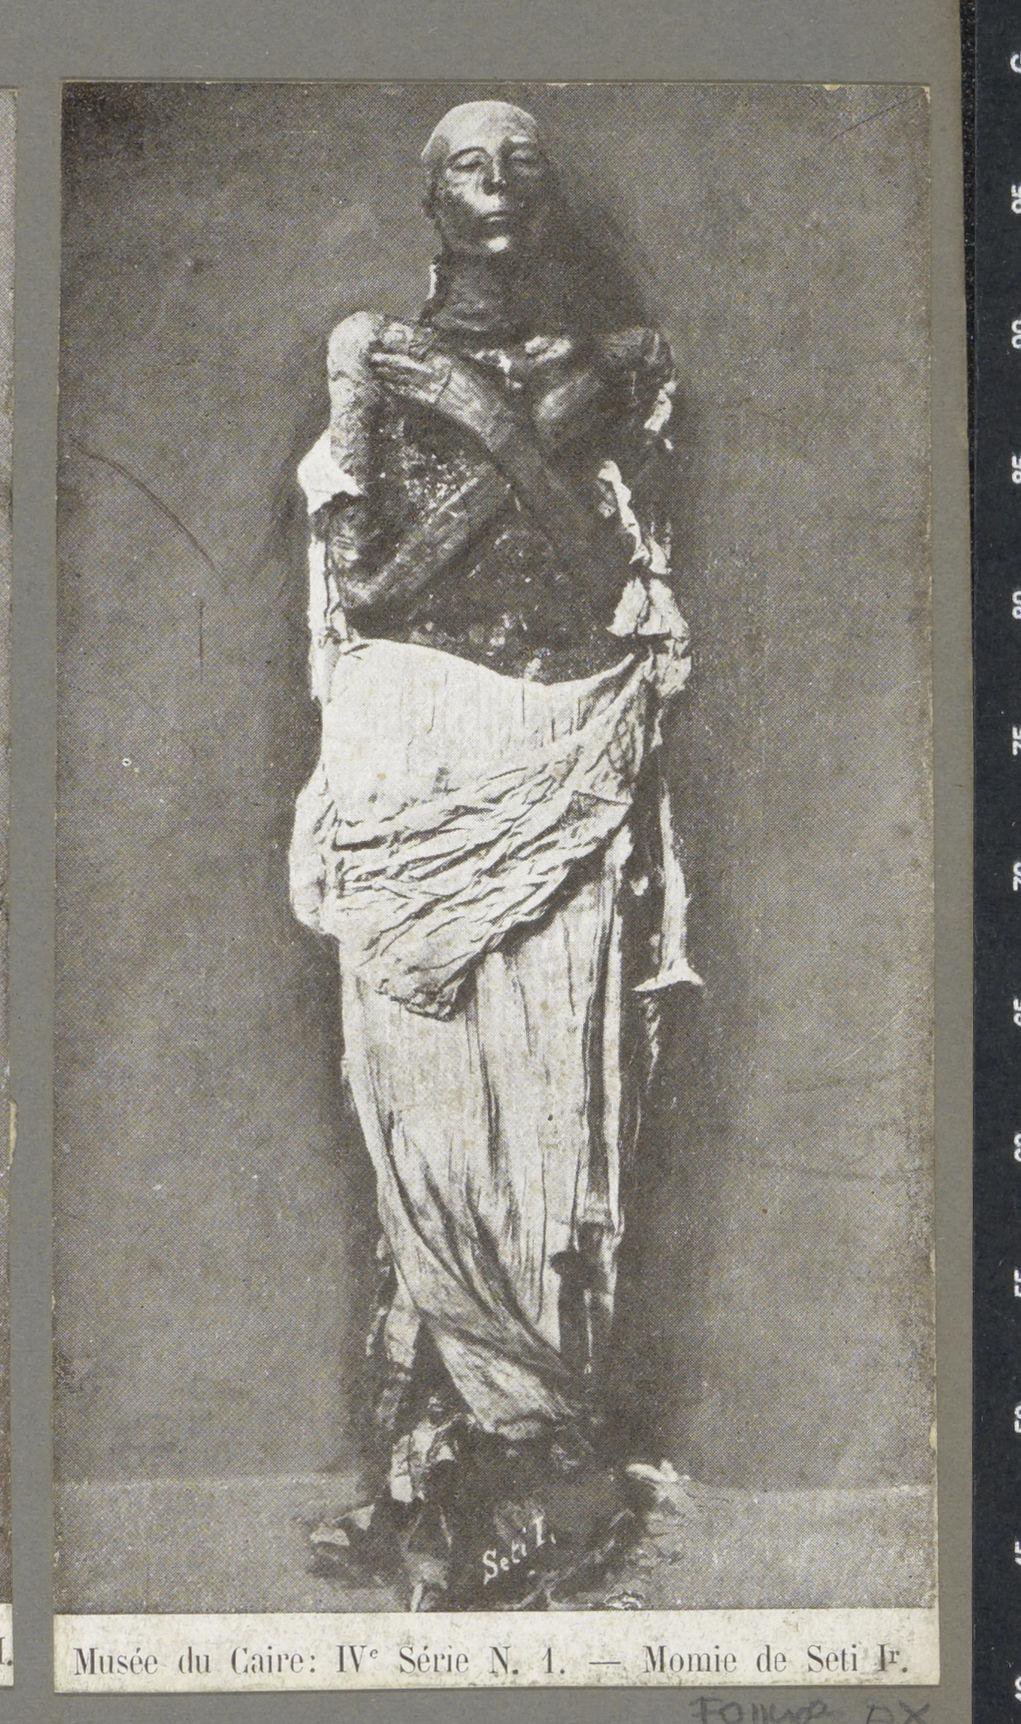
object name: album leaf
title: Musée du Caire: Momie de Seti Ir.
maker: Anonymous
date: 1895-1905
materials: paper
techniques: autotype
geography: cairo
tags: permanent exhibition, museum, mummy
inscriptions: number: ‘IVe Série N. 1’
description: Onderdeel van Reisalbum met foto's van bezienswaardigheden in Griekenland en Egypte.